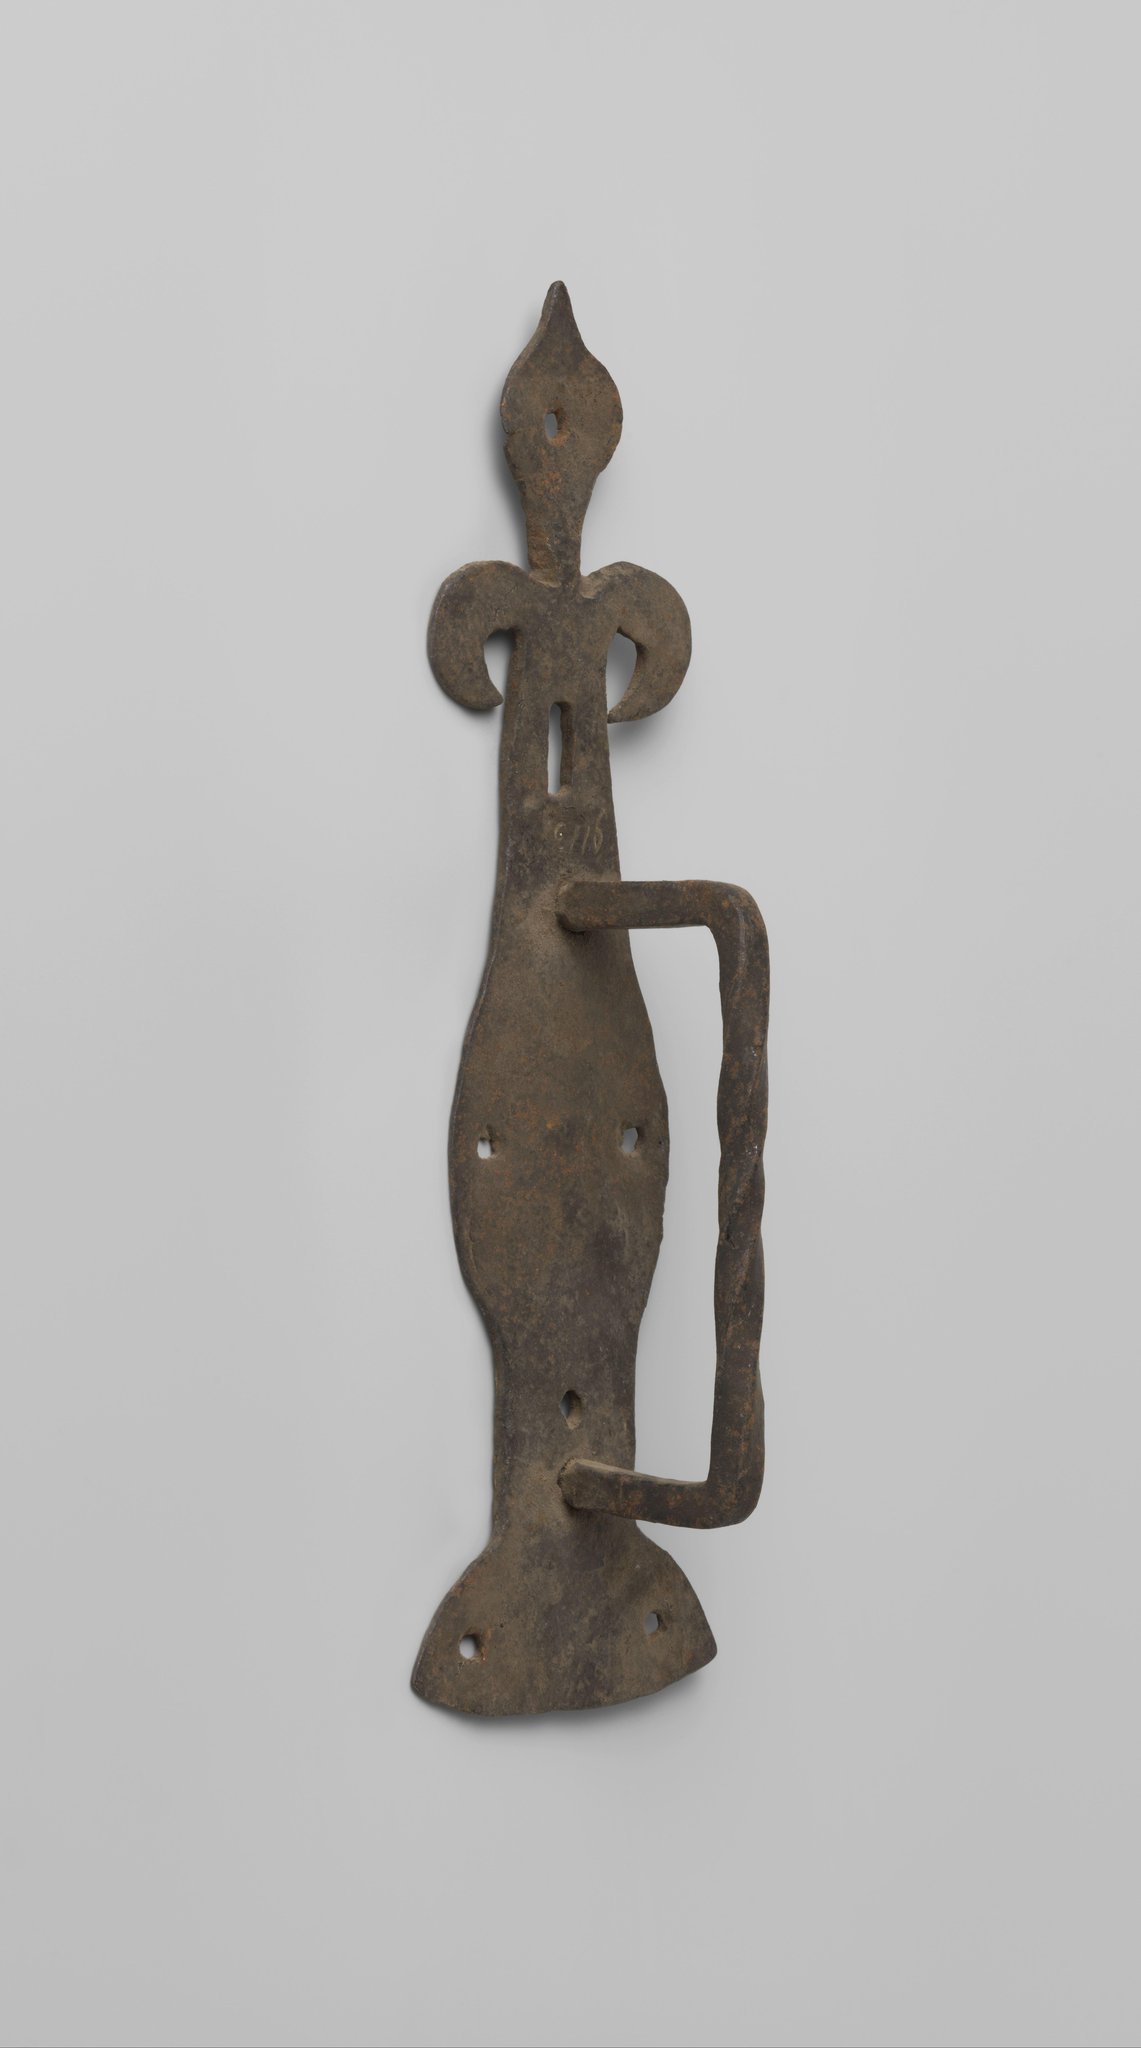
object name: deurtrekker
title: Deurtrekker met lelie als versiering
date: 1400-1950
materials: iron